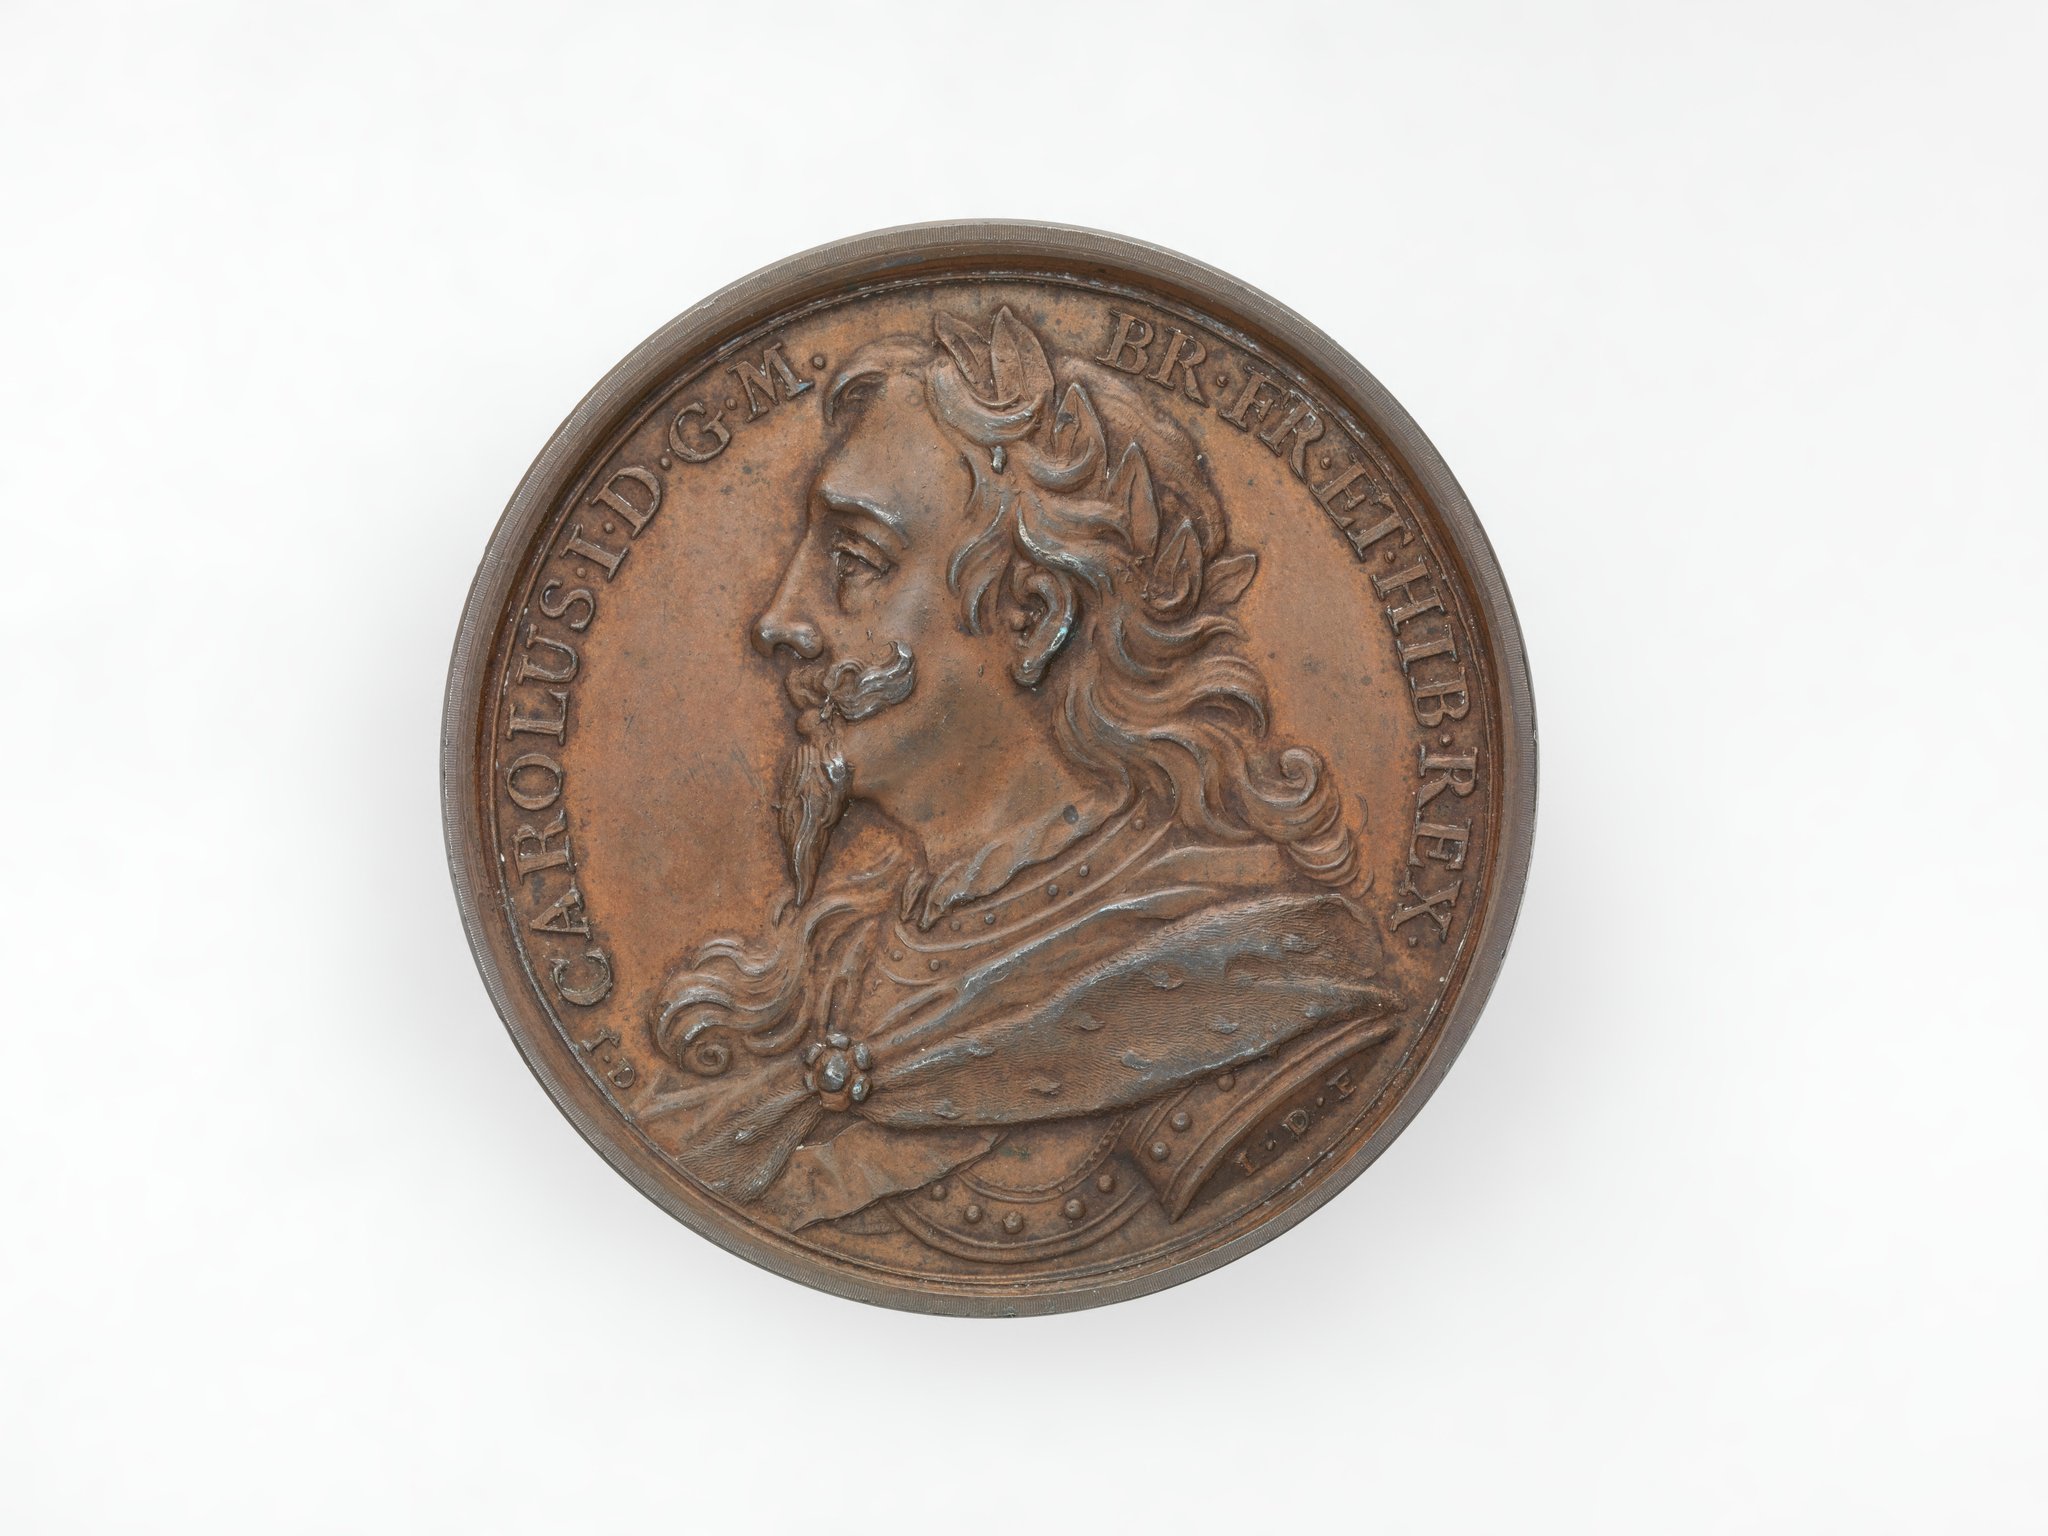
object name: medal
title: Charles I, from the English Monarchs series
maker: jean dassier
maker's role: artist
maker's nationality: swiss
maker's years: 1676-1763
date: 1731-1732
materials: bronze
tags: men,profiles